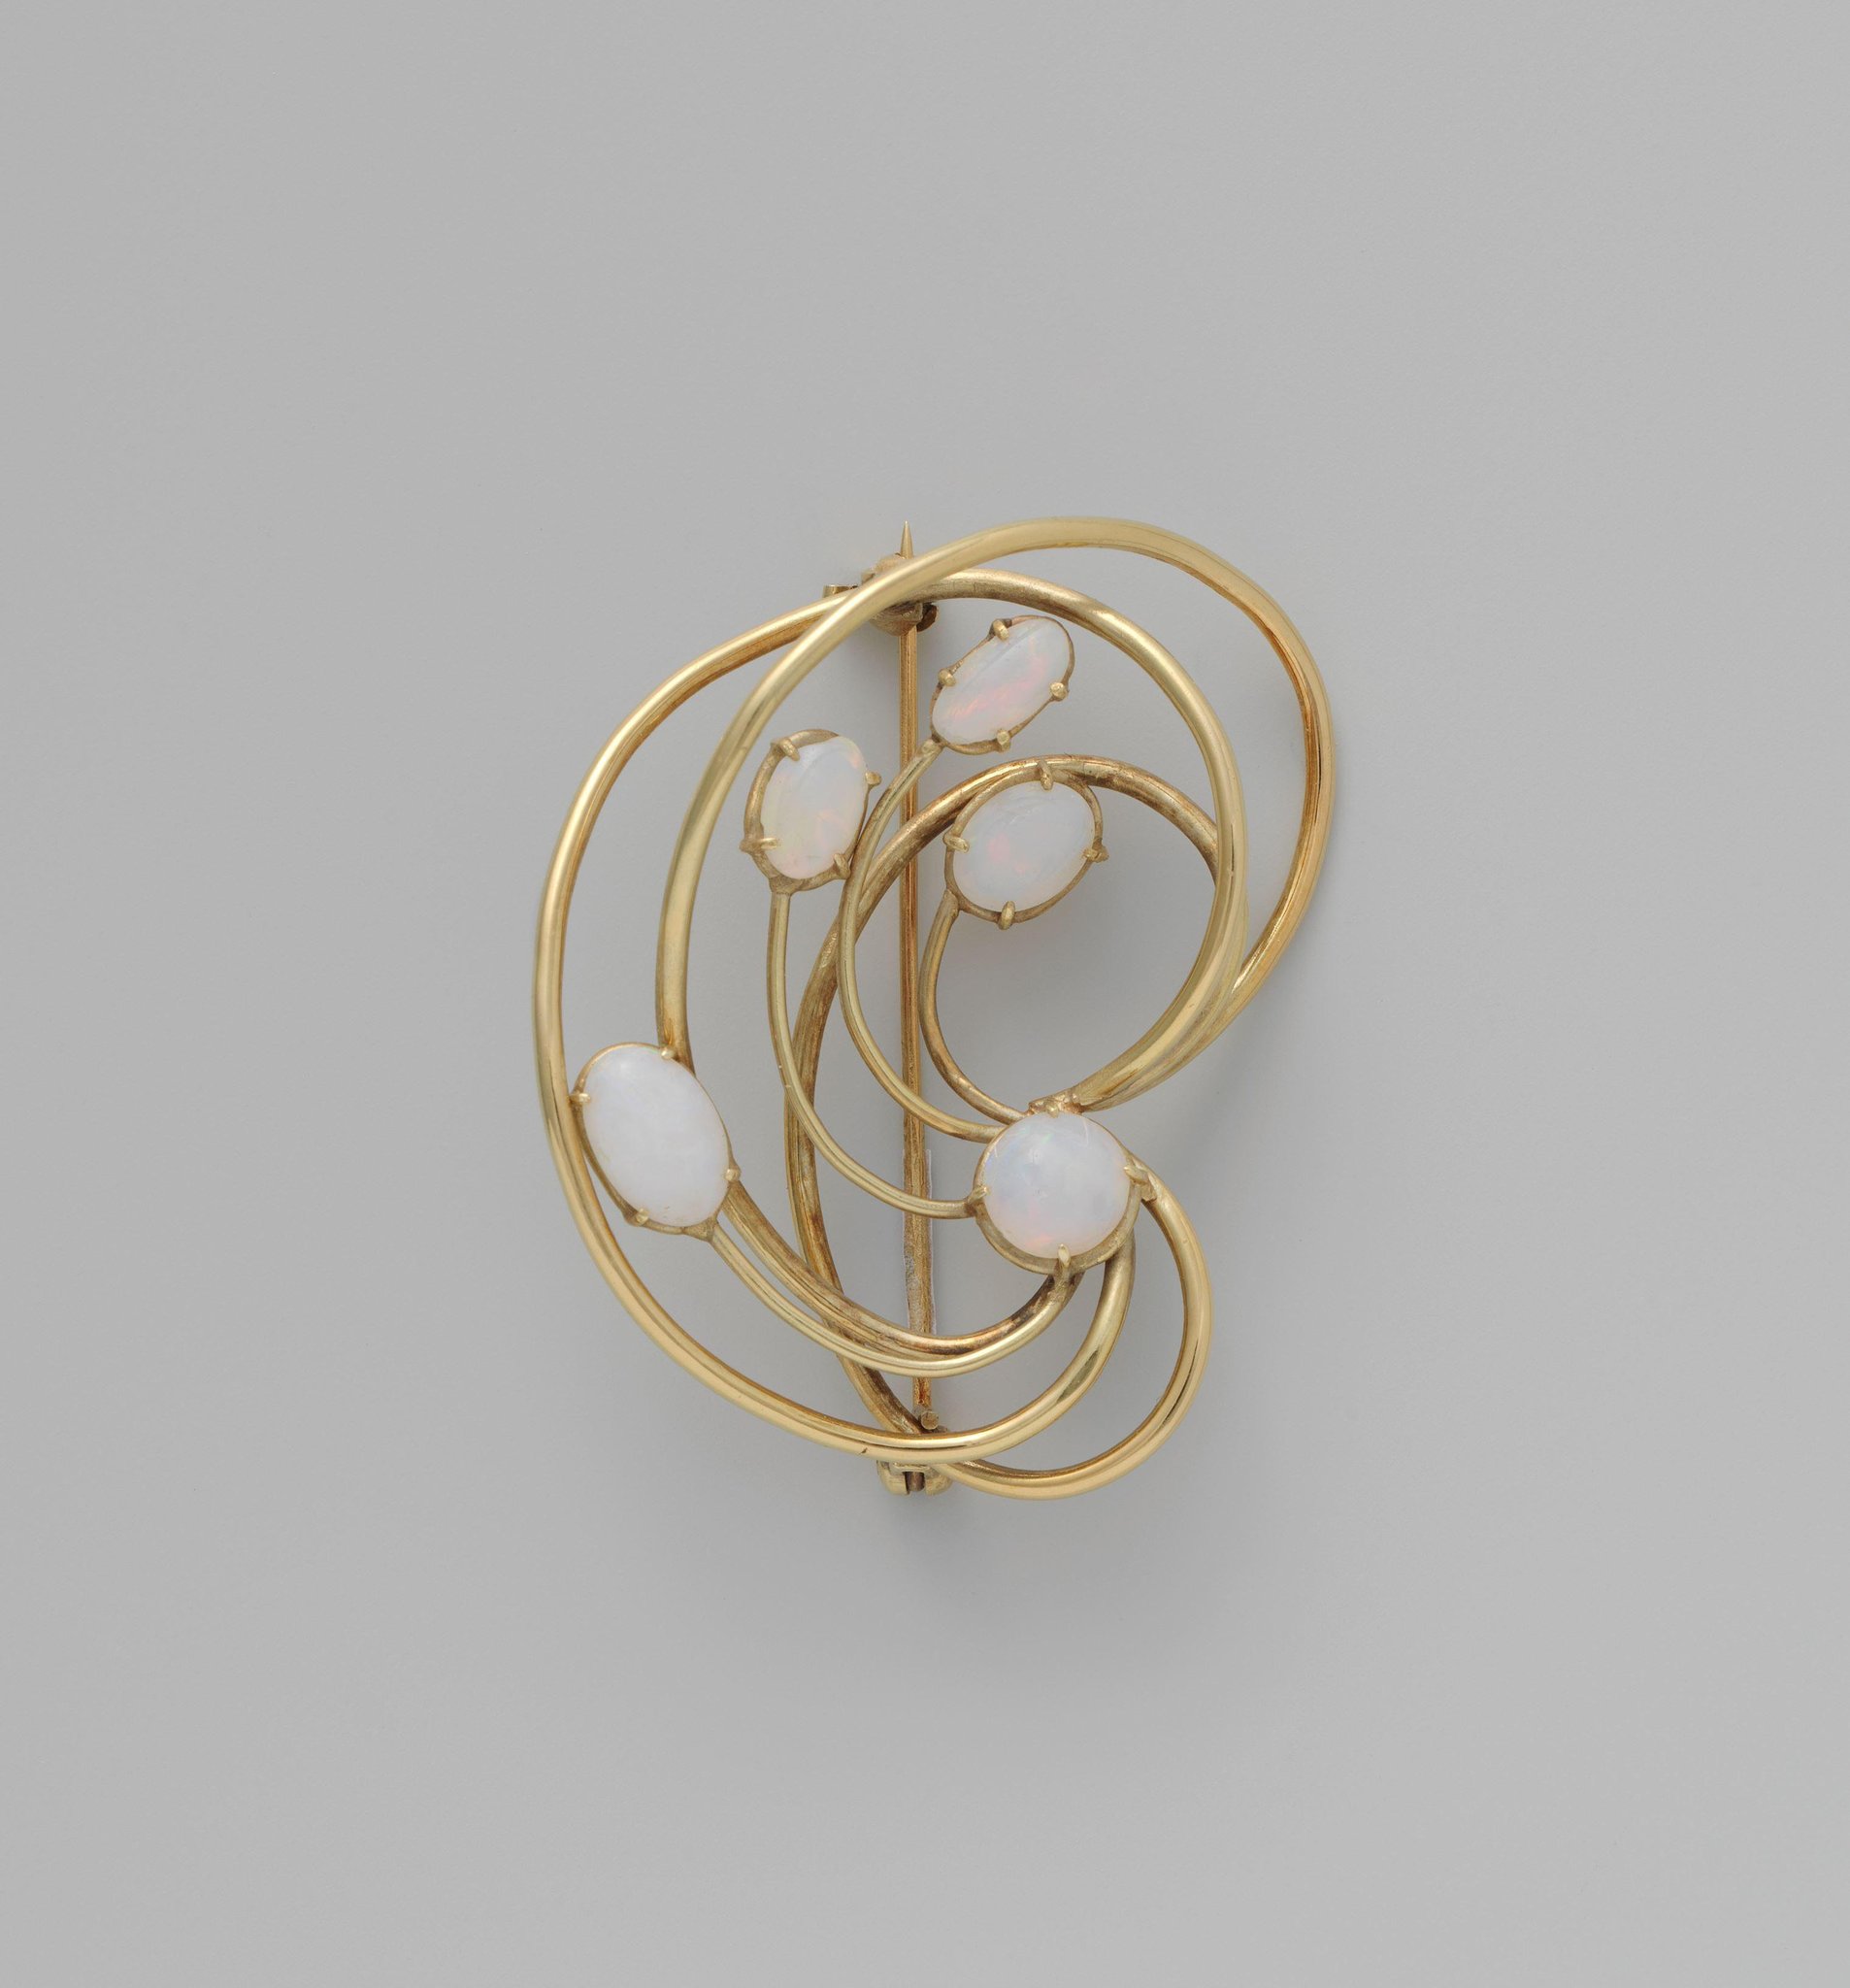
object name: brooch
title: Draadbroche van goud met vijf melkopalen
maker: j.f. homburger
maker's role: juwelier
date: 1953-1966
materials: gold, opal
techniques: grinding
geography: amsterdam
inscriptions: maker's mark, alloy mark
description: Draadbroche van goud met vijf melkopalen voorzien van een kogelsluiting. Vier opalen zijn ovaal cabochon geslepen en één rond cabochon.